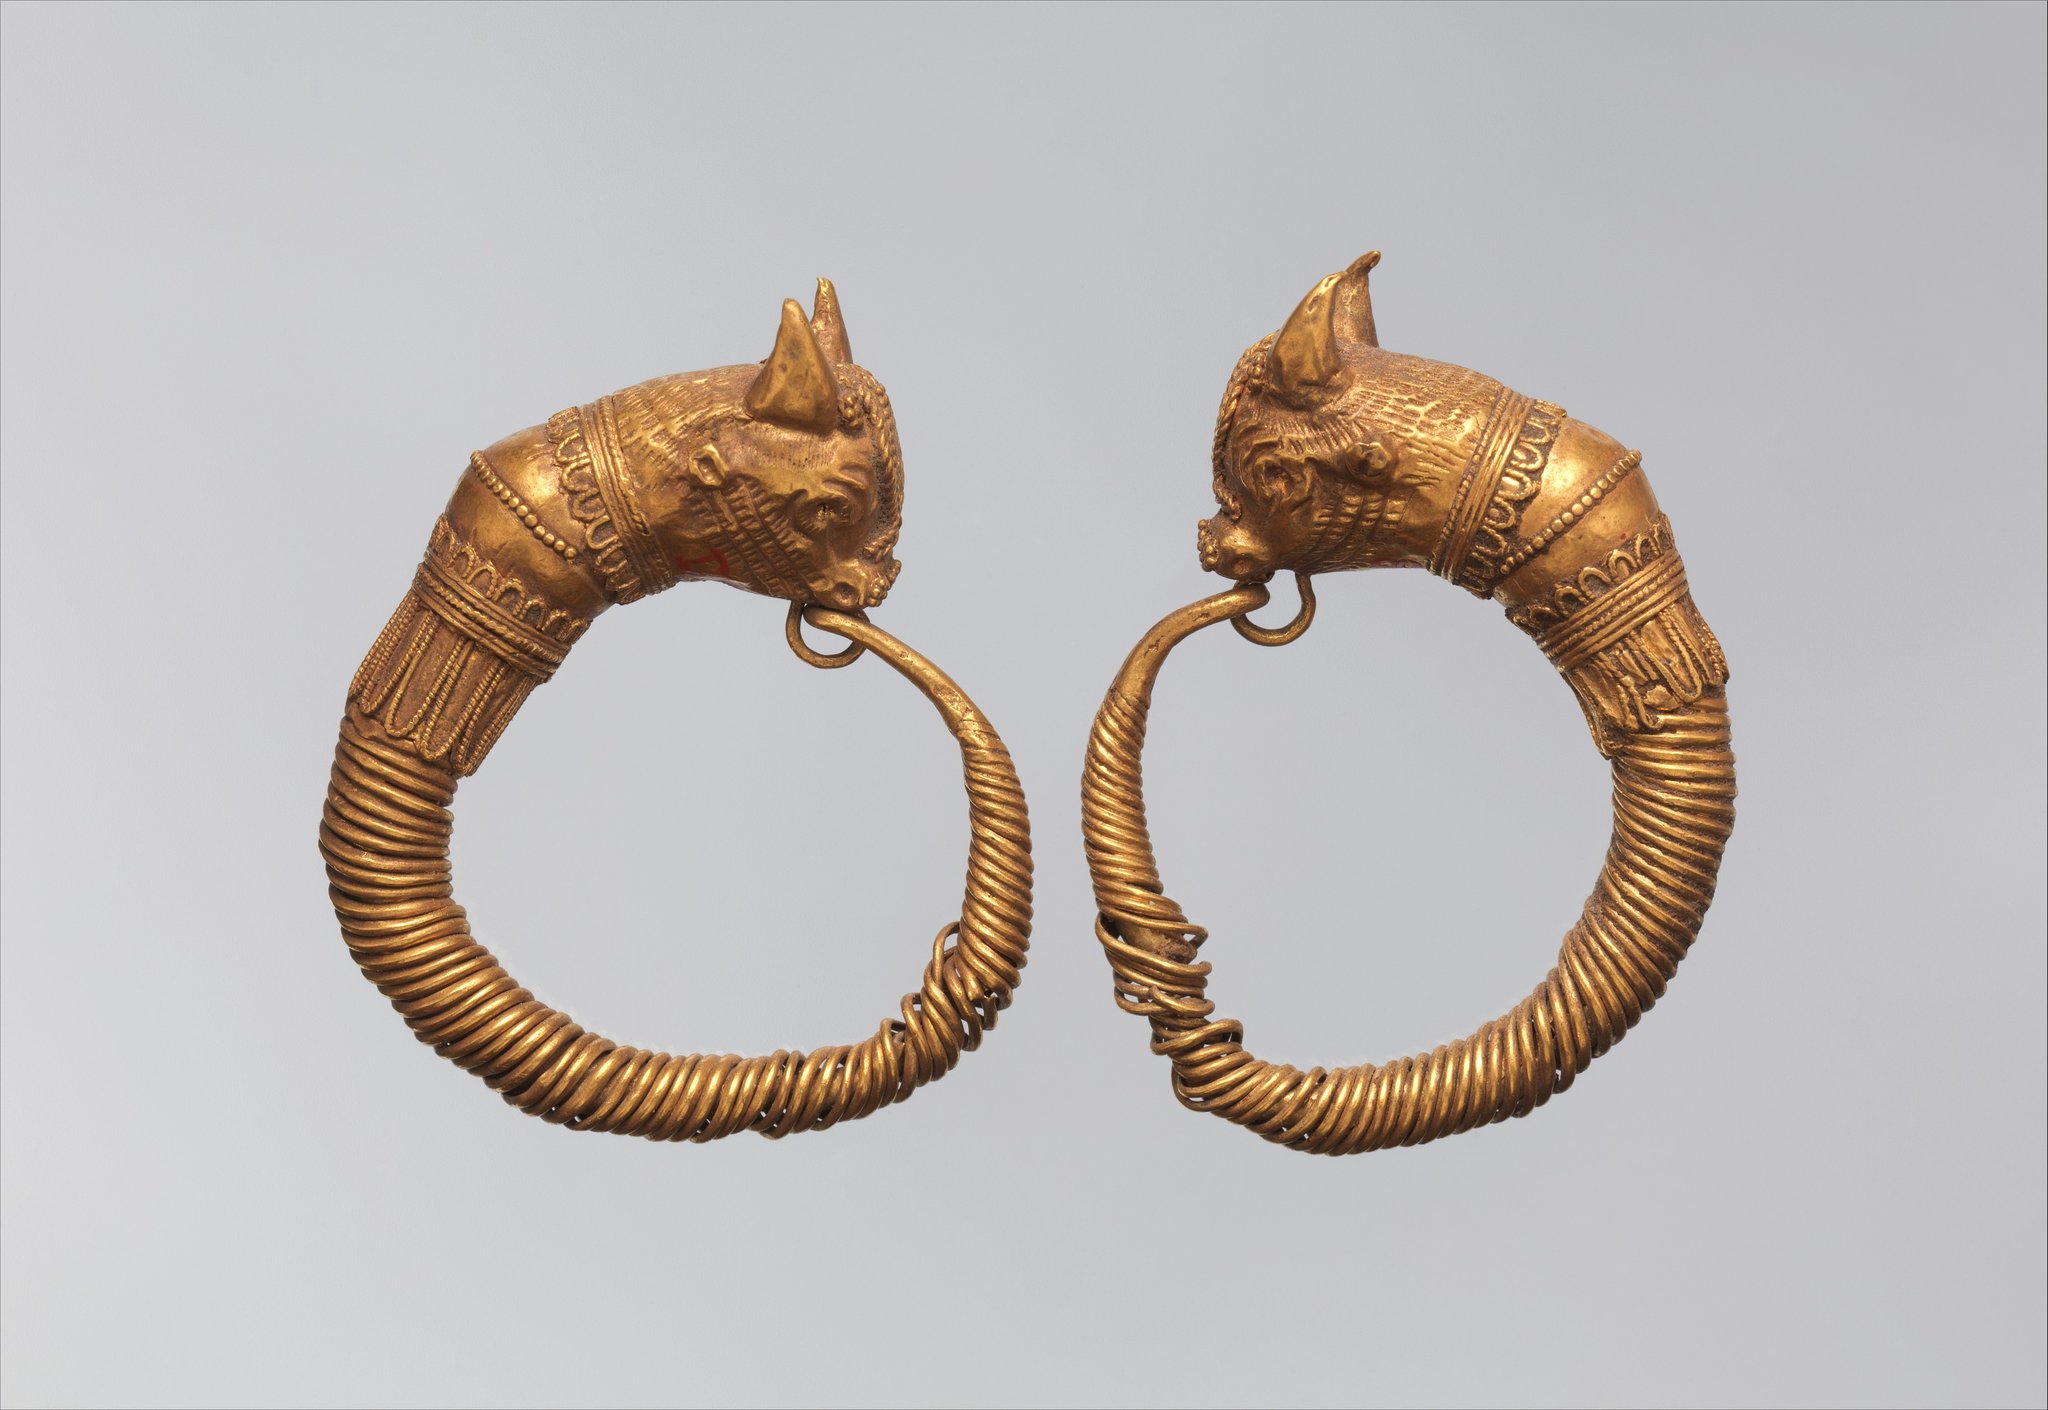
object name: earring with head of bull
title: Earring with head of a bull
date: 200-1 BCE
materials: gold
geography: egypt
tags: bulls